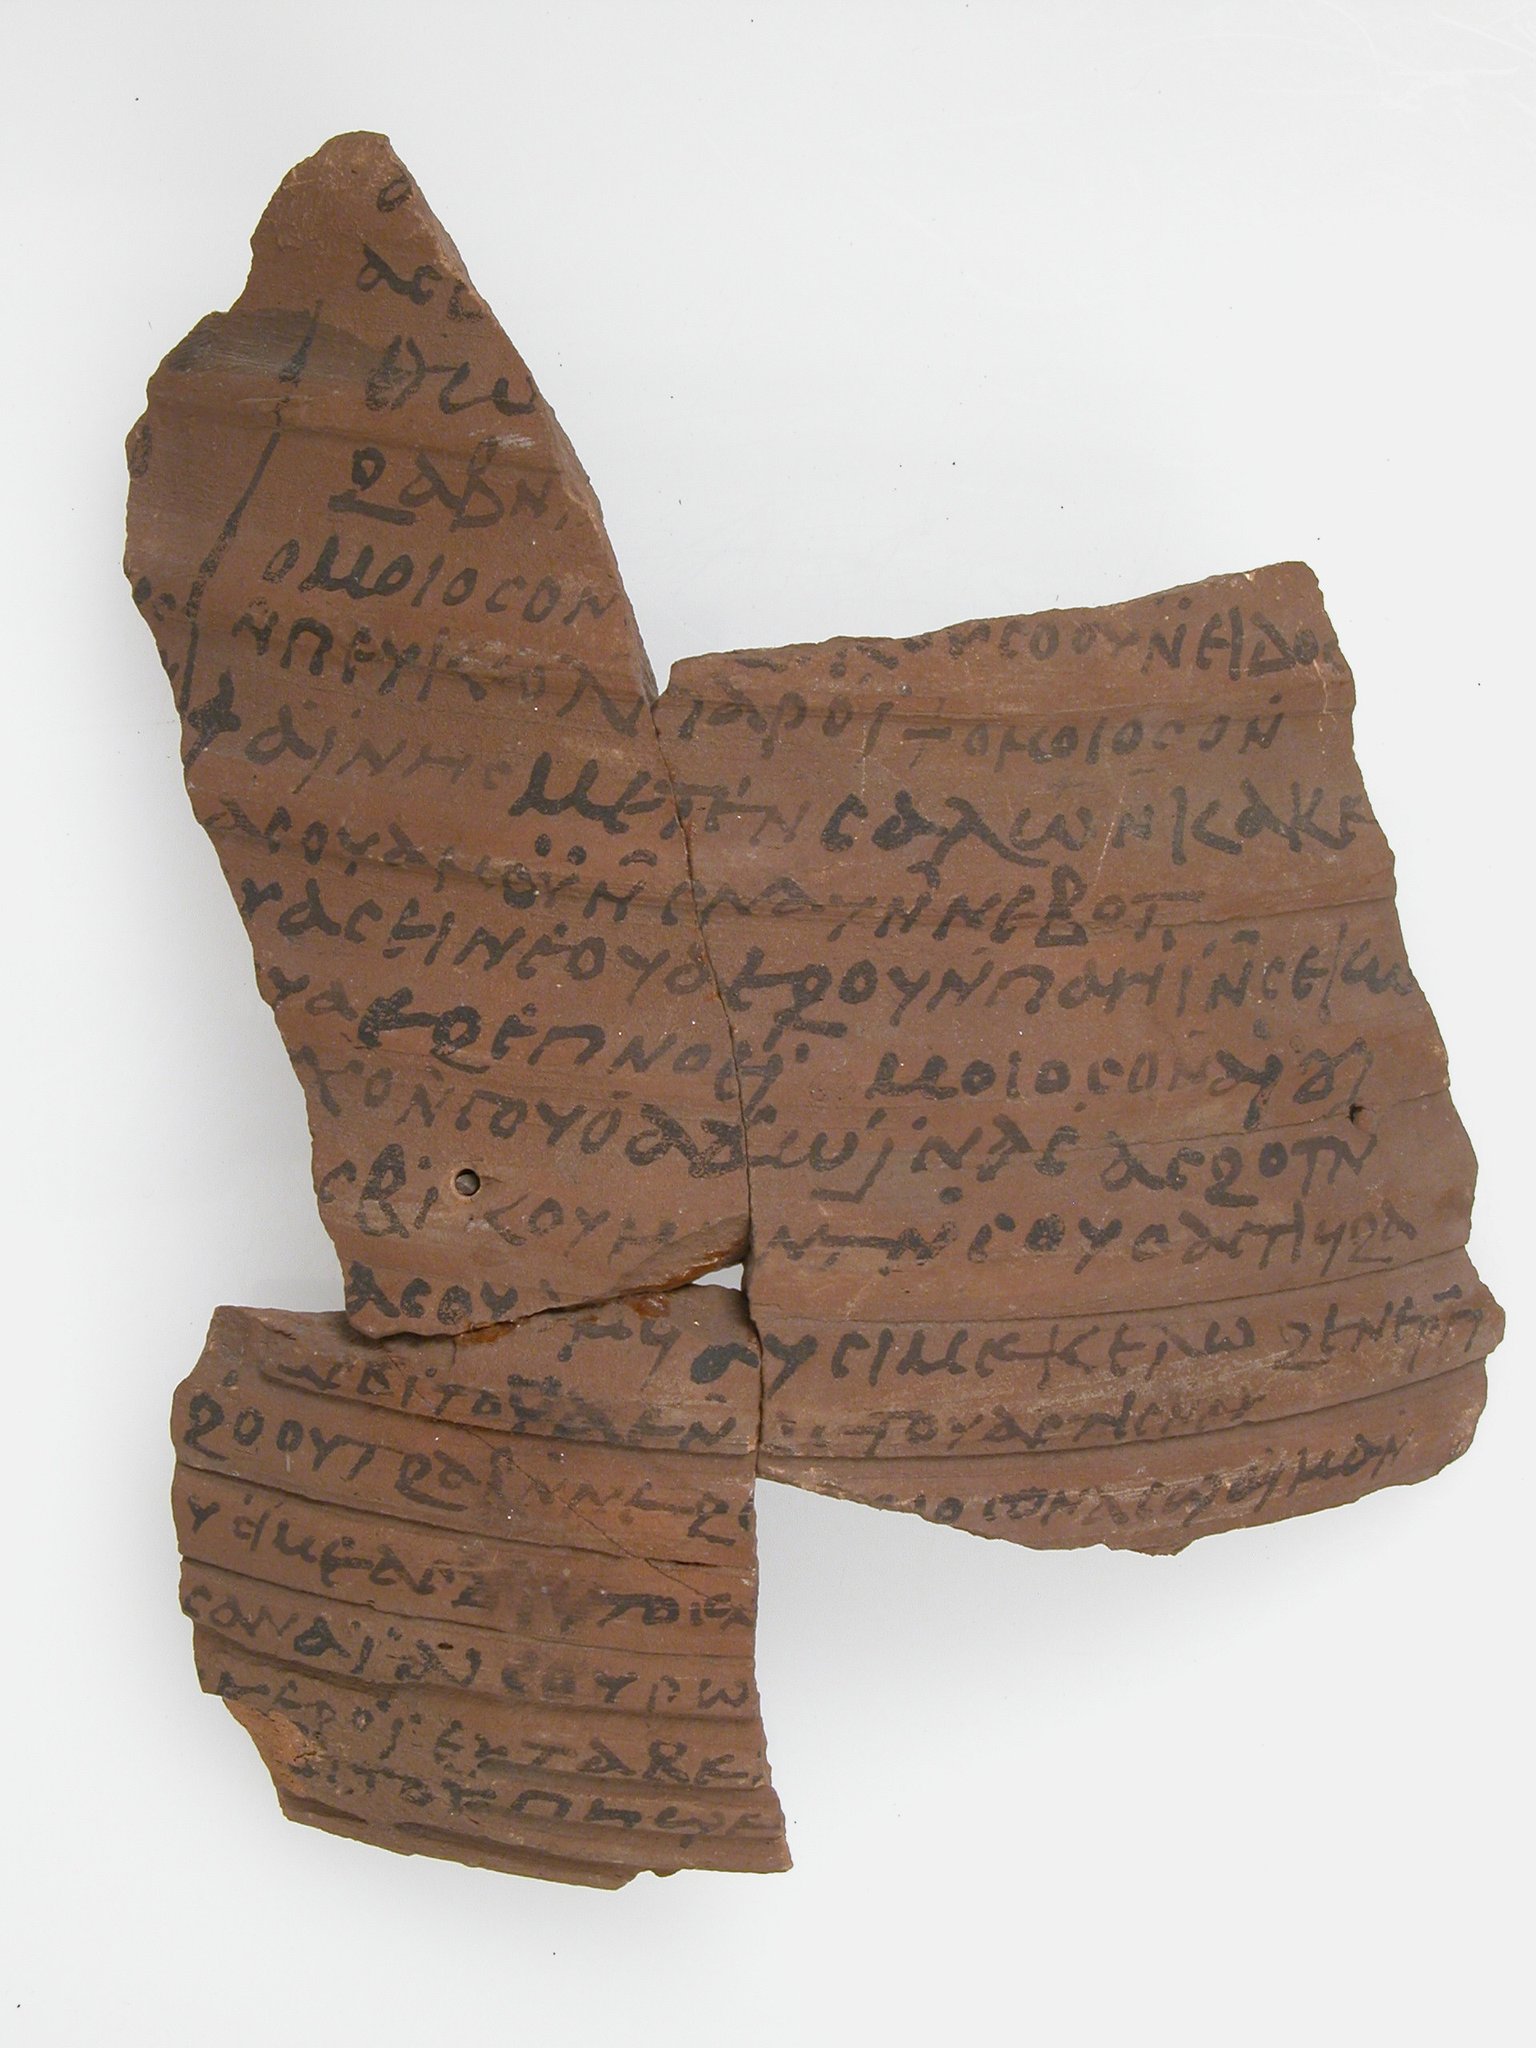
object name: ostrakon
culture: coptic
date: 601-700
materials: ink, pottery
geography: egypt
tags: documents